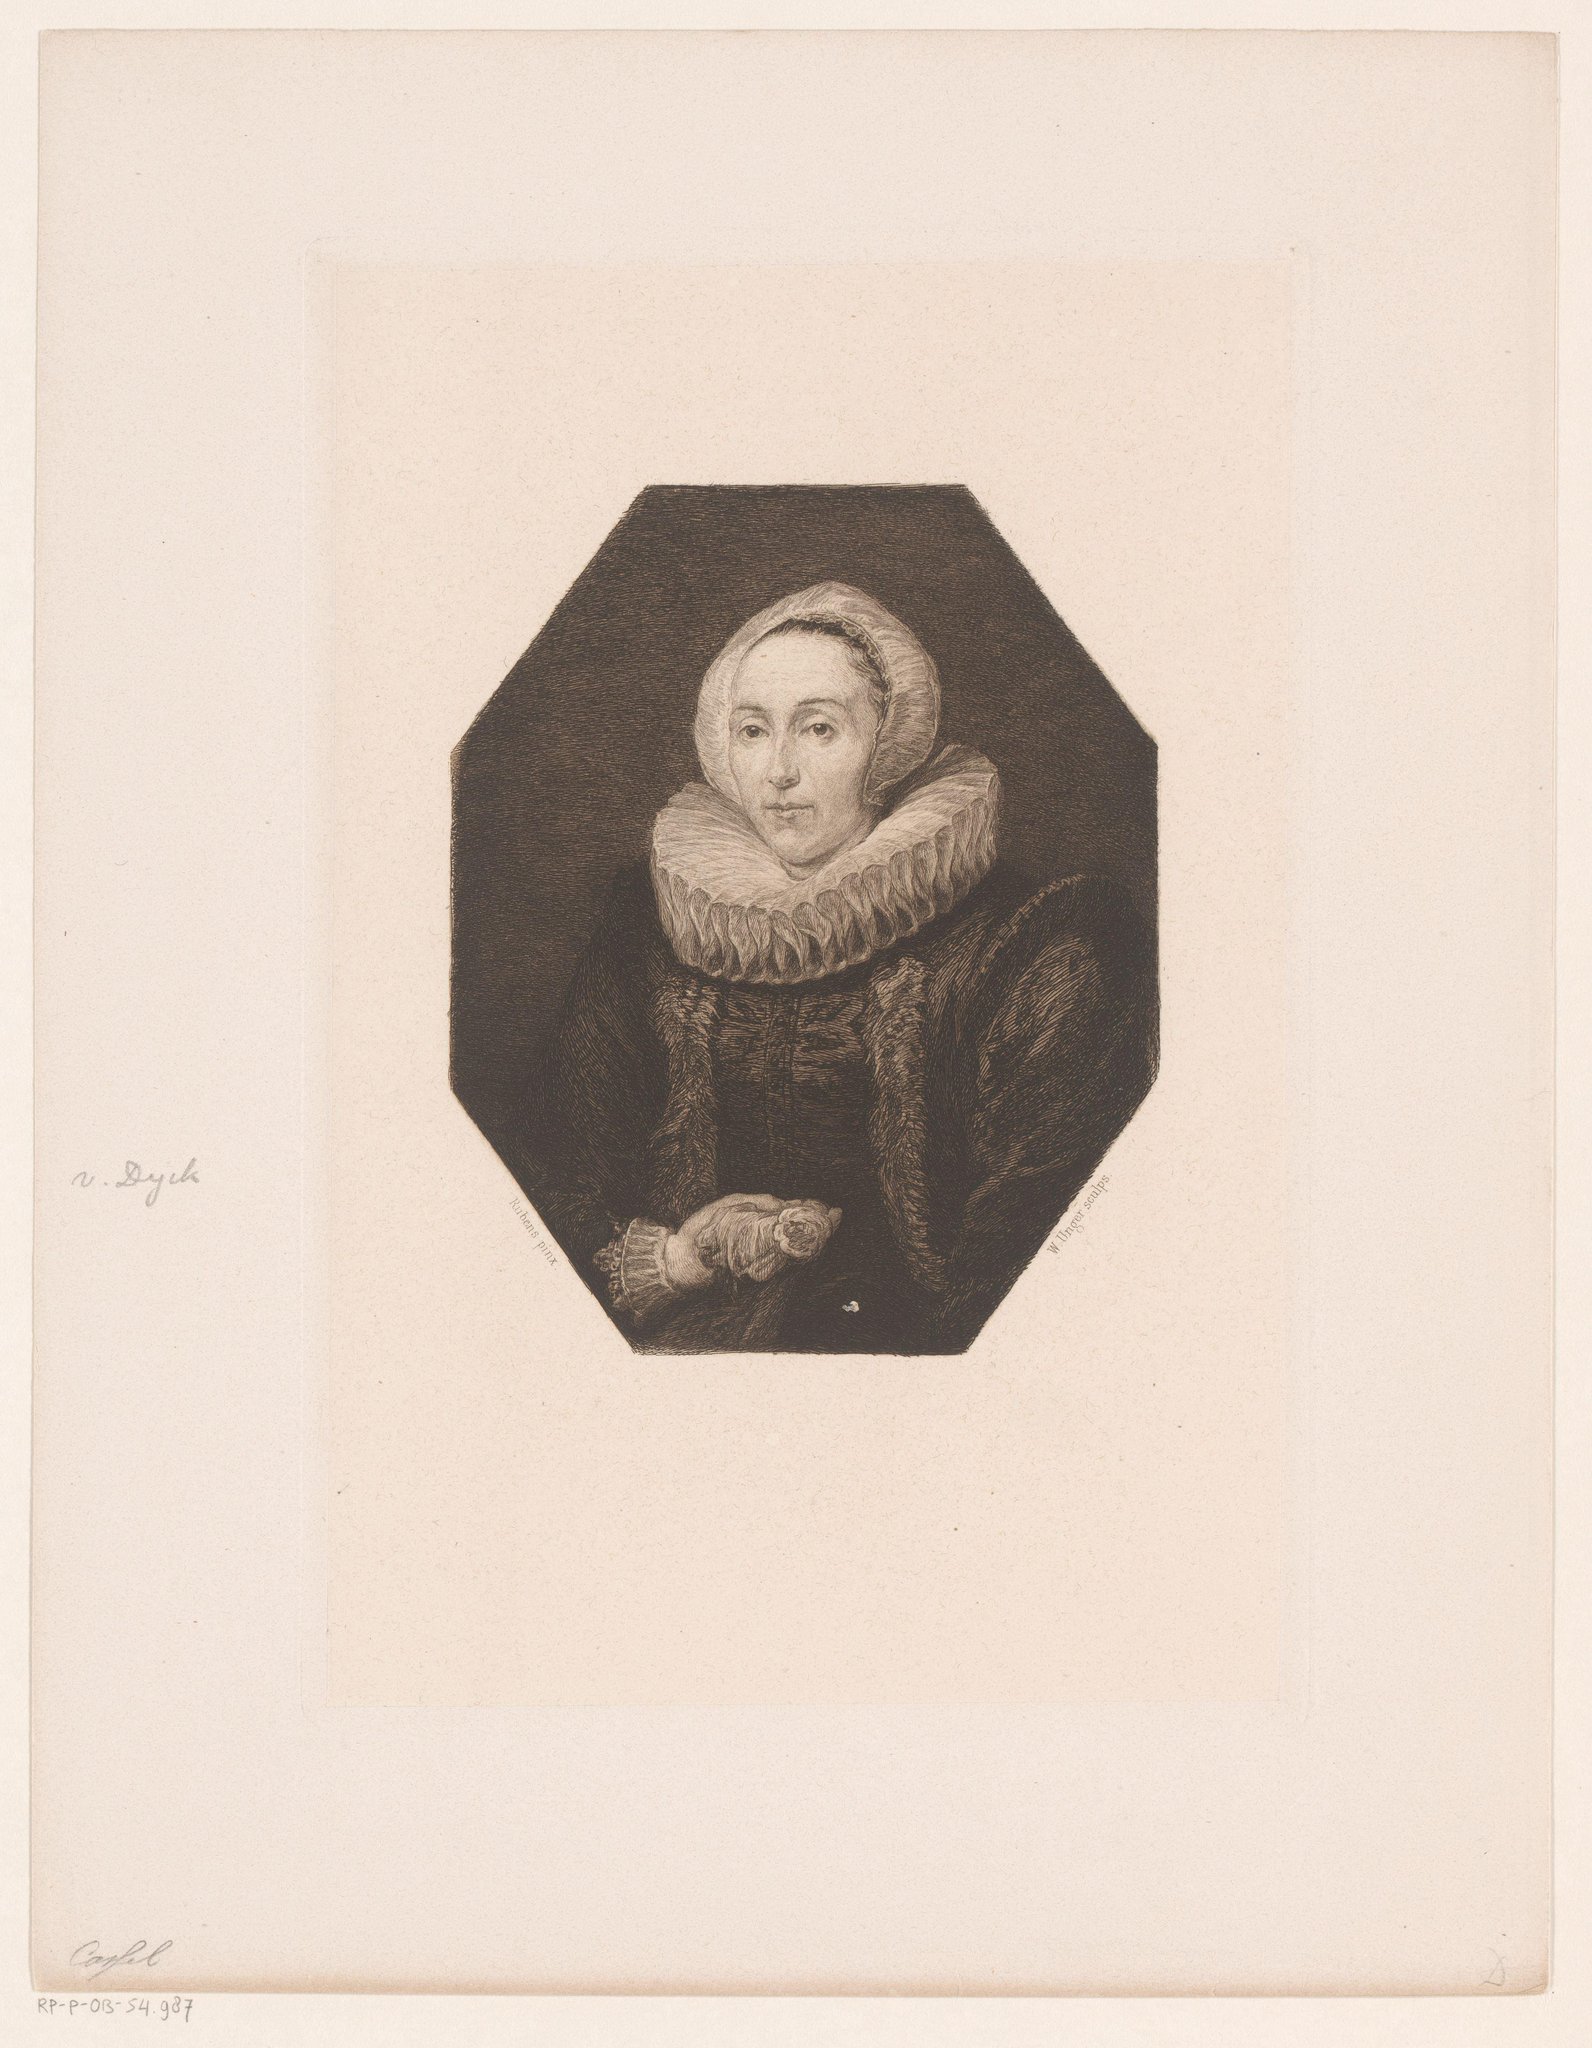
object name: print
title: Portret van een onbekende vrouw met een roos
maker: william unger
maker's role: draughtsman, painter, print maker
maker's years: 1837-1932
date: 1847-1889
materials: paper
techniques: etching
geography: germany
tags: historical persons, flowers: rose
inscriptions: collector's mark: Lugt 2228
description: Prent naar het schilderij door Anthony van Dyck in de Gemäldegalerie Alte Meister te Kassel (inv.nr. GK 120).